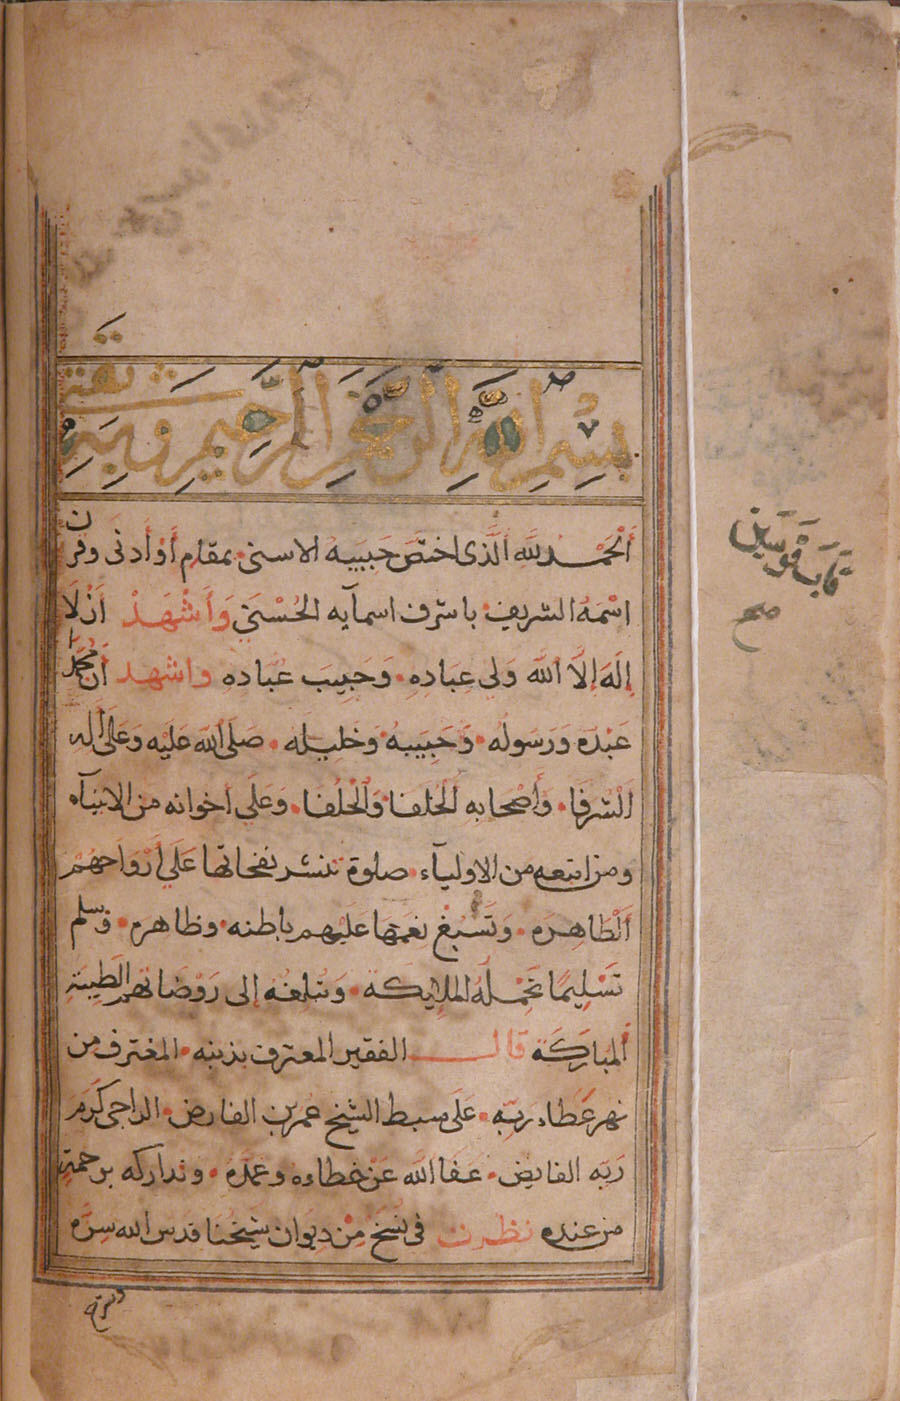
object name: non illustrated manuscript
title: Divan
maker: `umar ibn al-farid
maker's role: author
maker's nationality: egyptian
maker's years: 1181-1235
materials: gilt, gold, ink, leather, paper, watercolor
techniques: stamping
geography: iran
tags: arabic